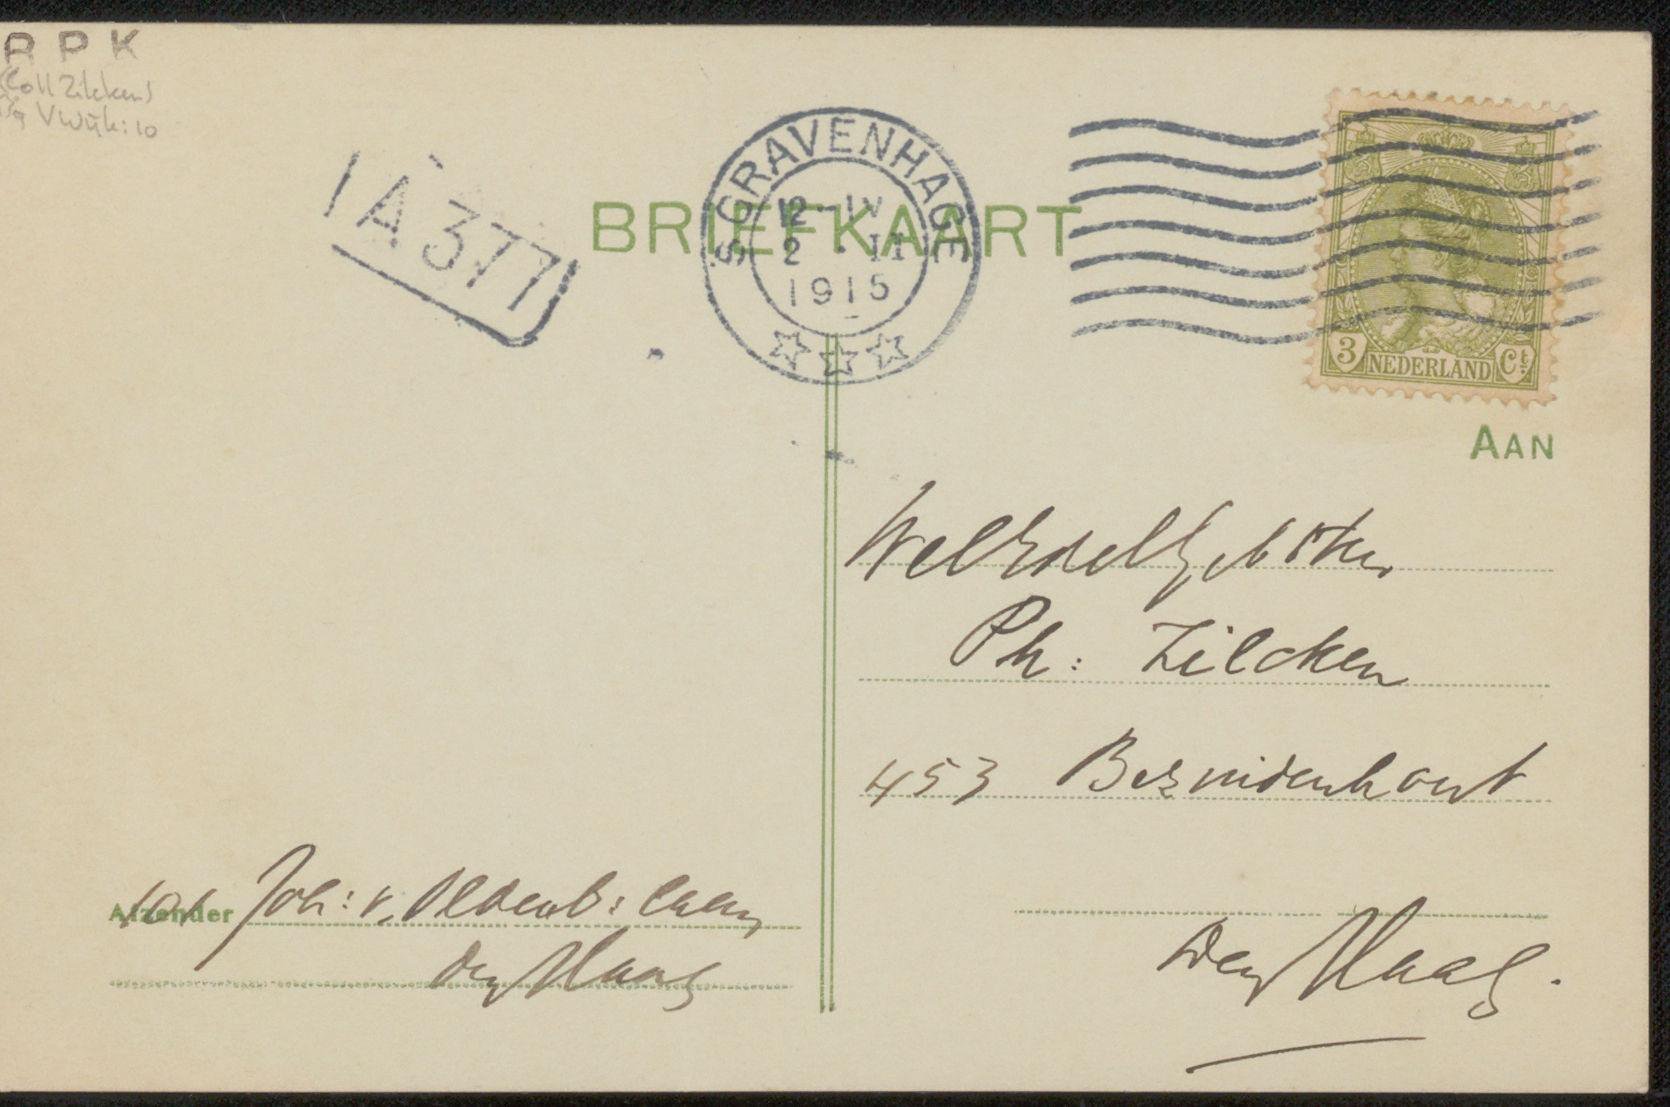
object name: postcard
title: Briefkaart aan Philip Zilcken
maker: charles van wijk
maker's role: sculptor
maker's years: 1875-1917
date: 1915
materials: cardboard, ink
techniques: pen, writing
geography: the hague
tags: the hague, painter, draughtsman, philip zilcken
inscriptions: collector's mark: ‘RPK’